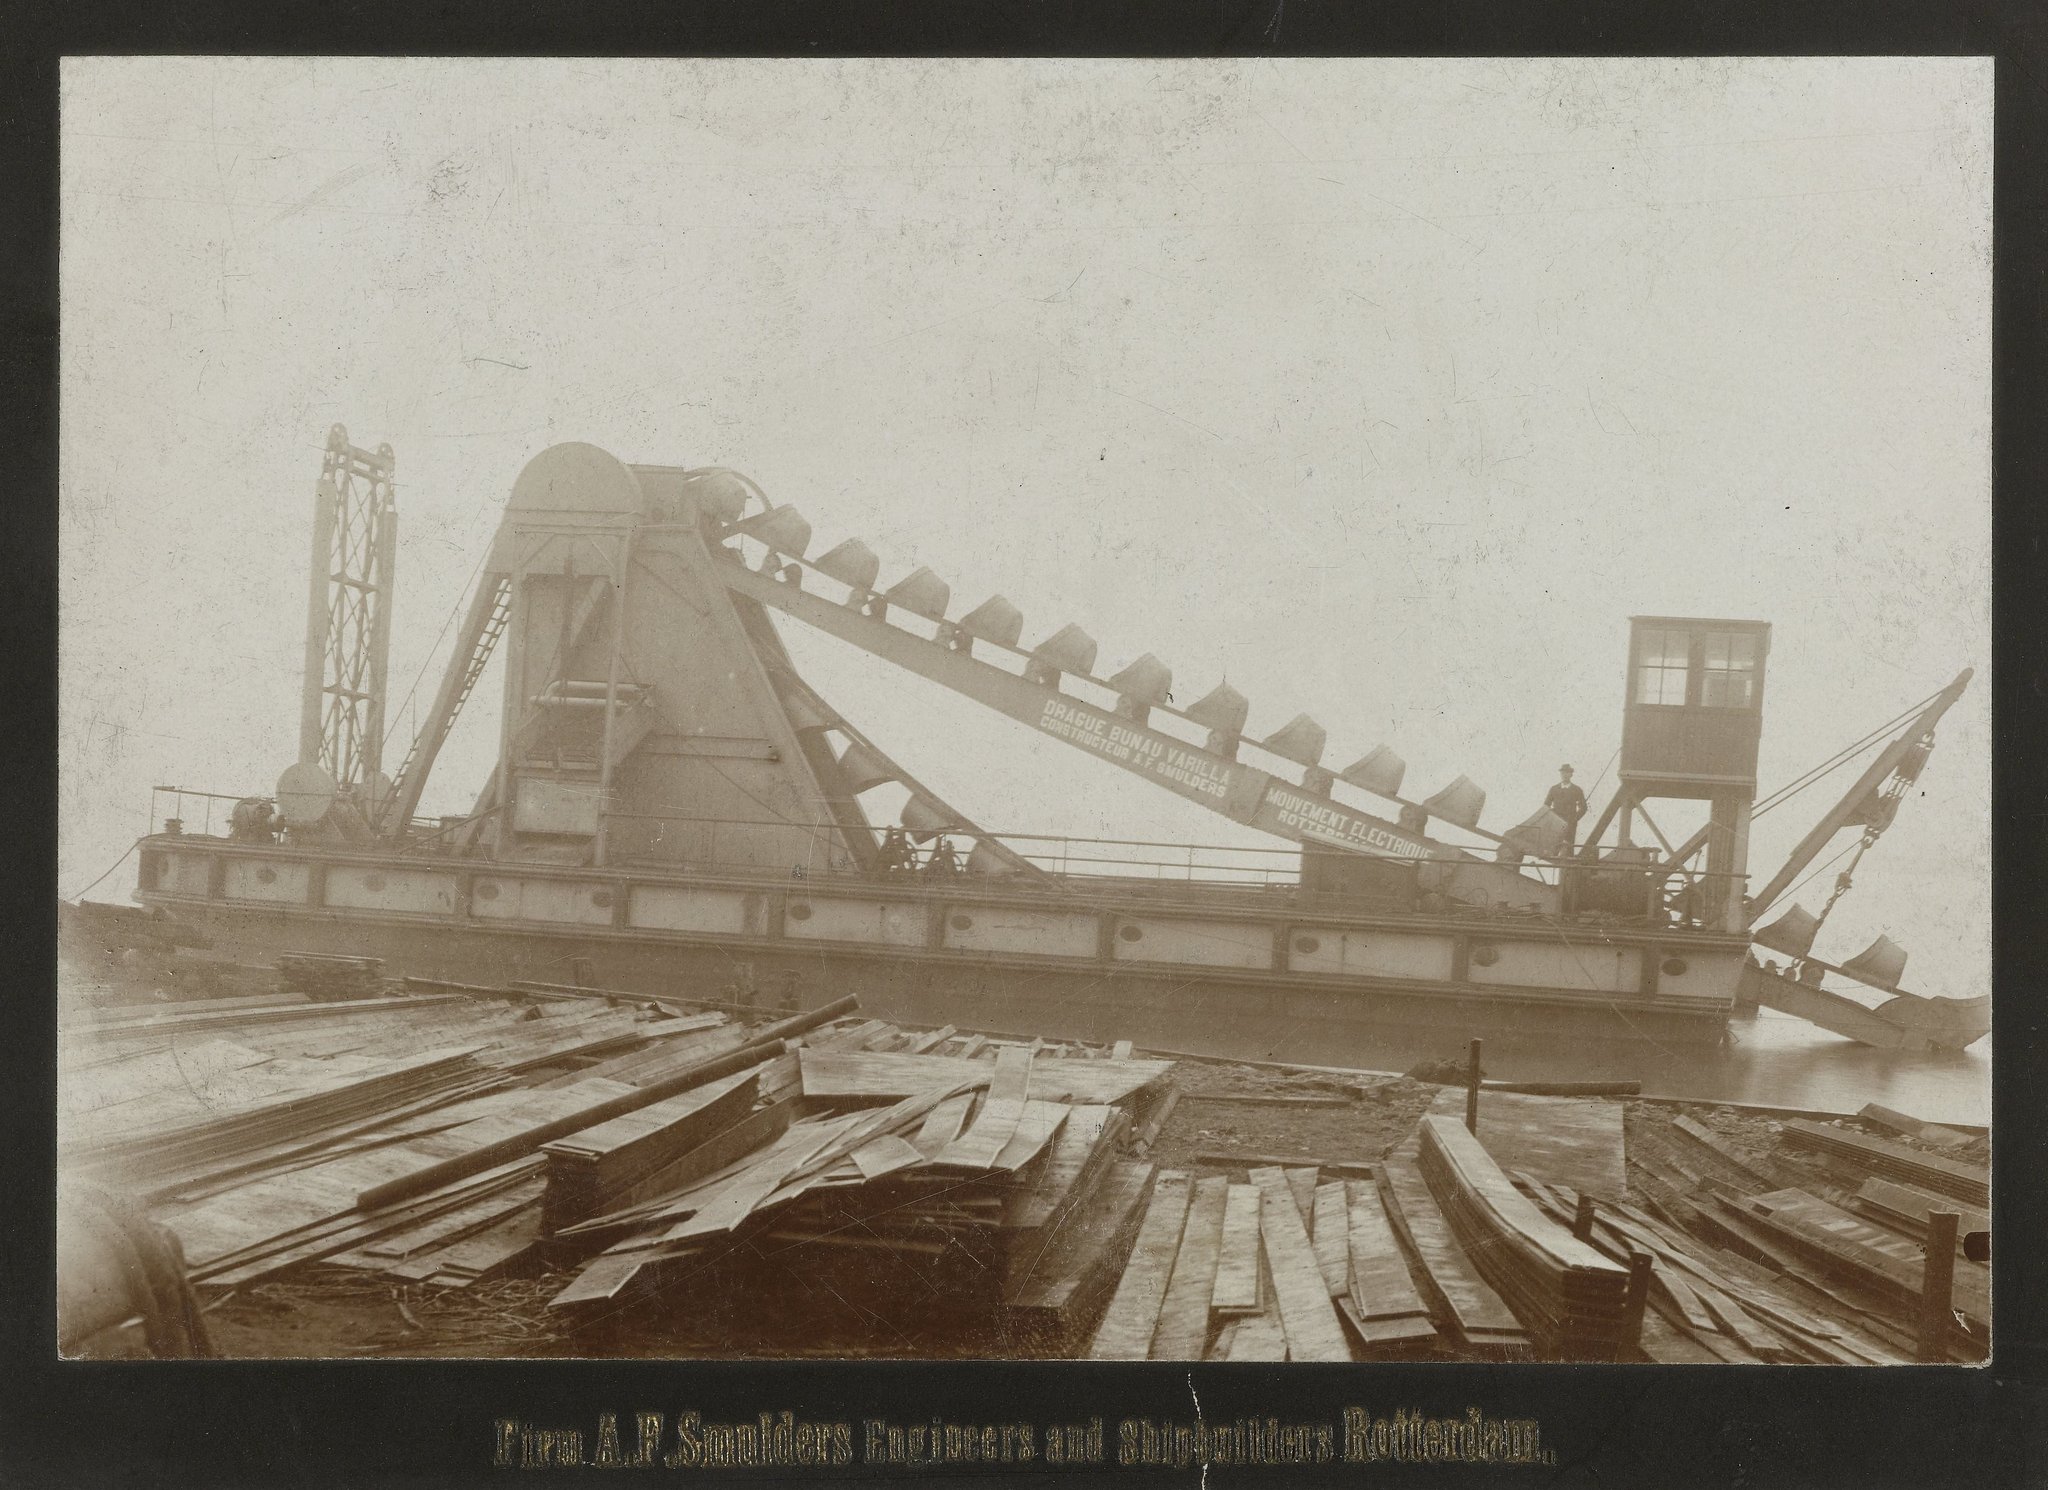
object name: photograph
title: Firma A.F. Smulders Engineers and Shipbuilders Rotterdam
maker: Anonymous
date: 1900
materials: cardboard, paper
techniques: photography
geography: rotterdam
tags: rotterdam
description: Foto op karton van een baggermachine. Opschrift; o.: 'Firma A.F. Smulders Engineers and Shipbuilders Rotterdam'.